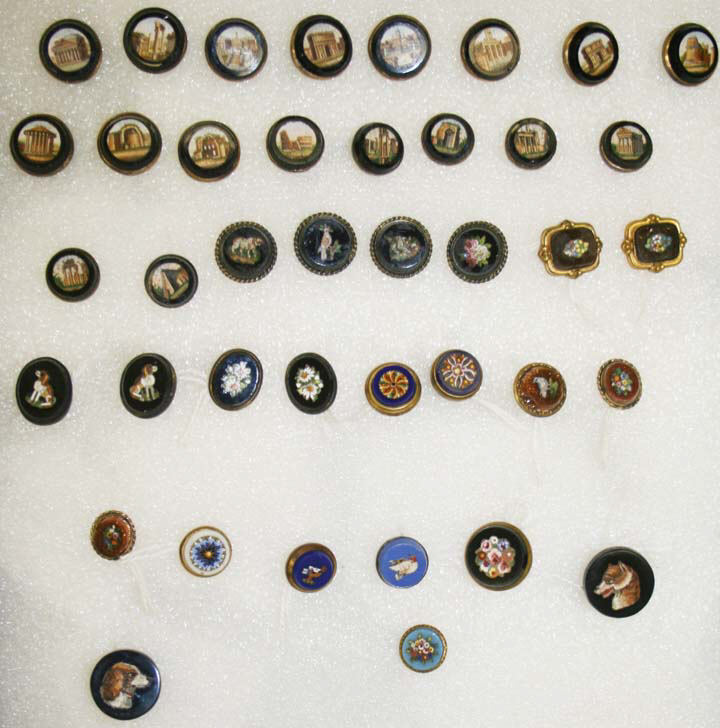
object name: button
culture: italian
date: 1860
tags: birds,buildings,dogs,roses